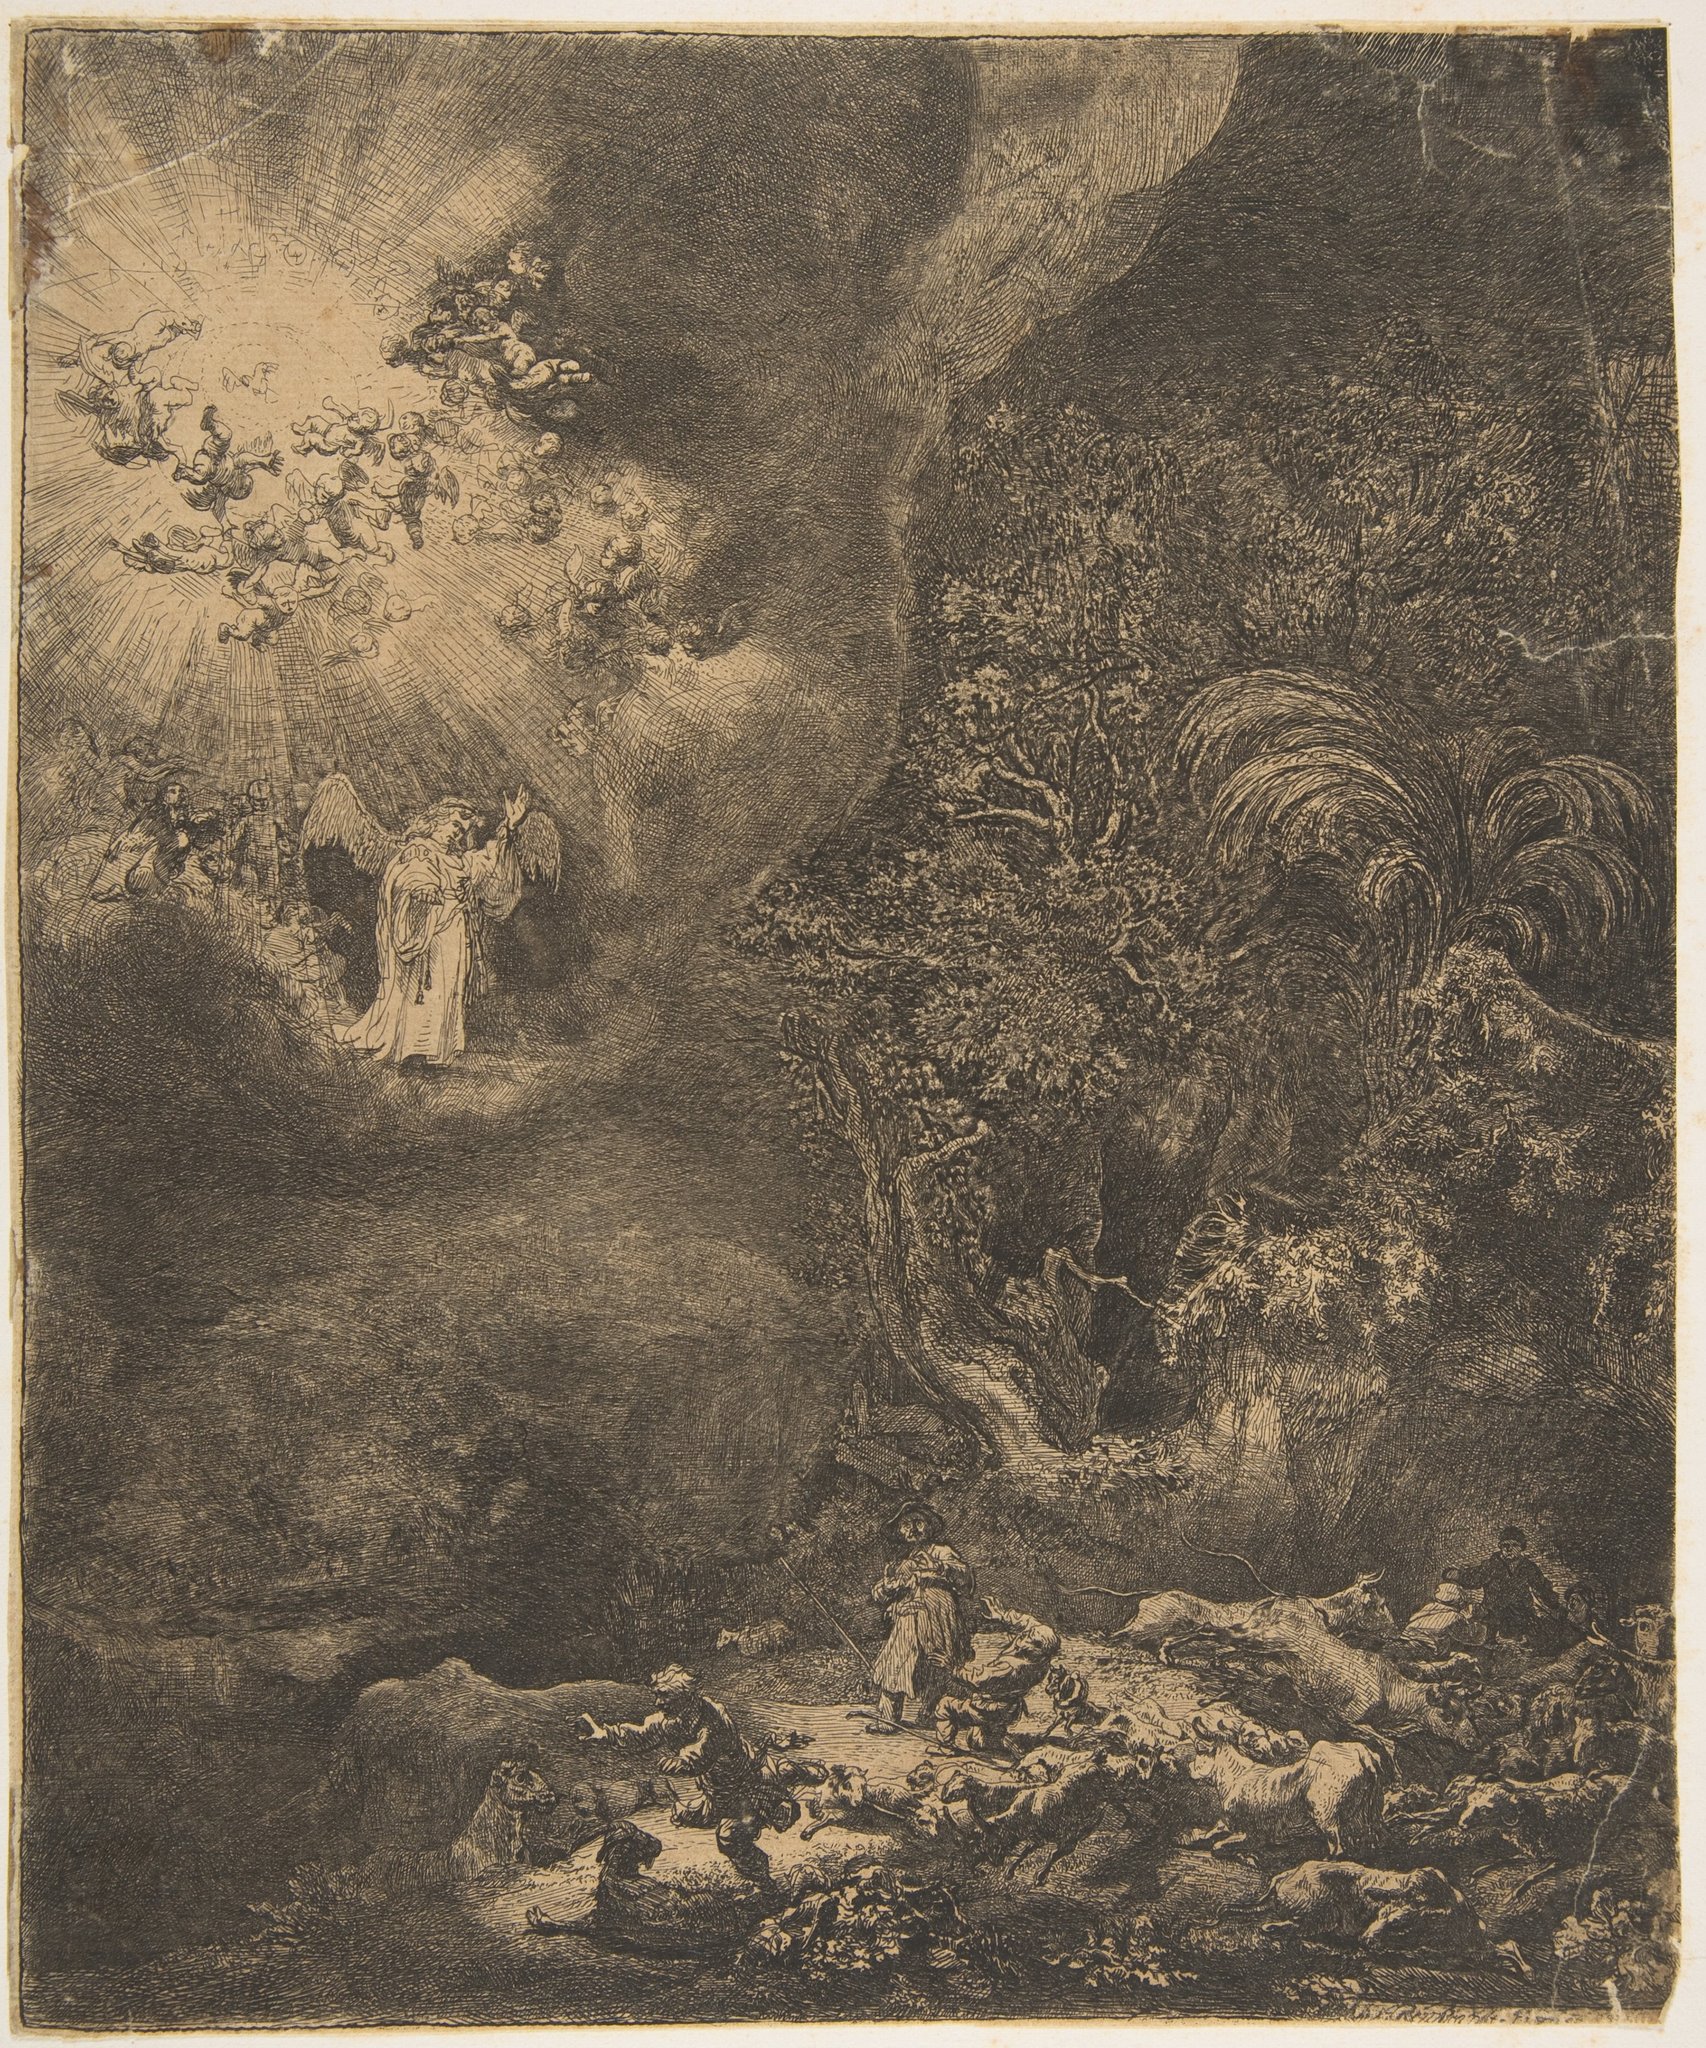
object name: print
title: The Angel Appearing to the Shepherds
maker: rembrandt van rijn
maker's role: artist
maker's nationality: dutch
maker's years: 1606-1669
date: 1634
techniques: engraving, drypoint, etching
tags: animals,trees,angels,shepherds